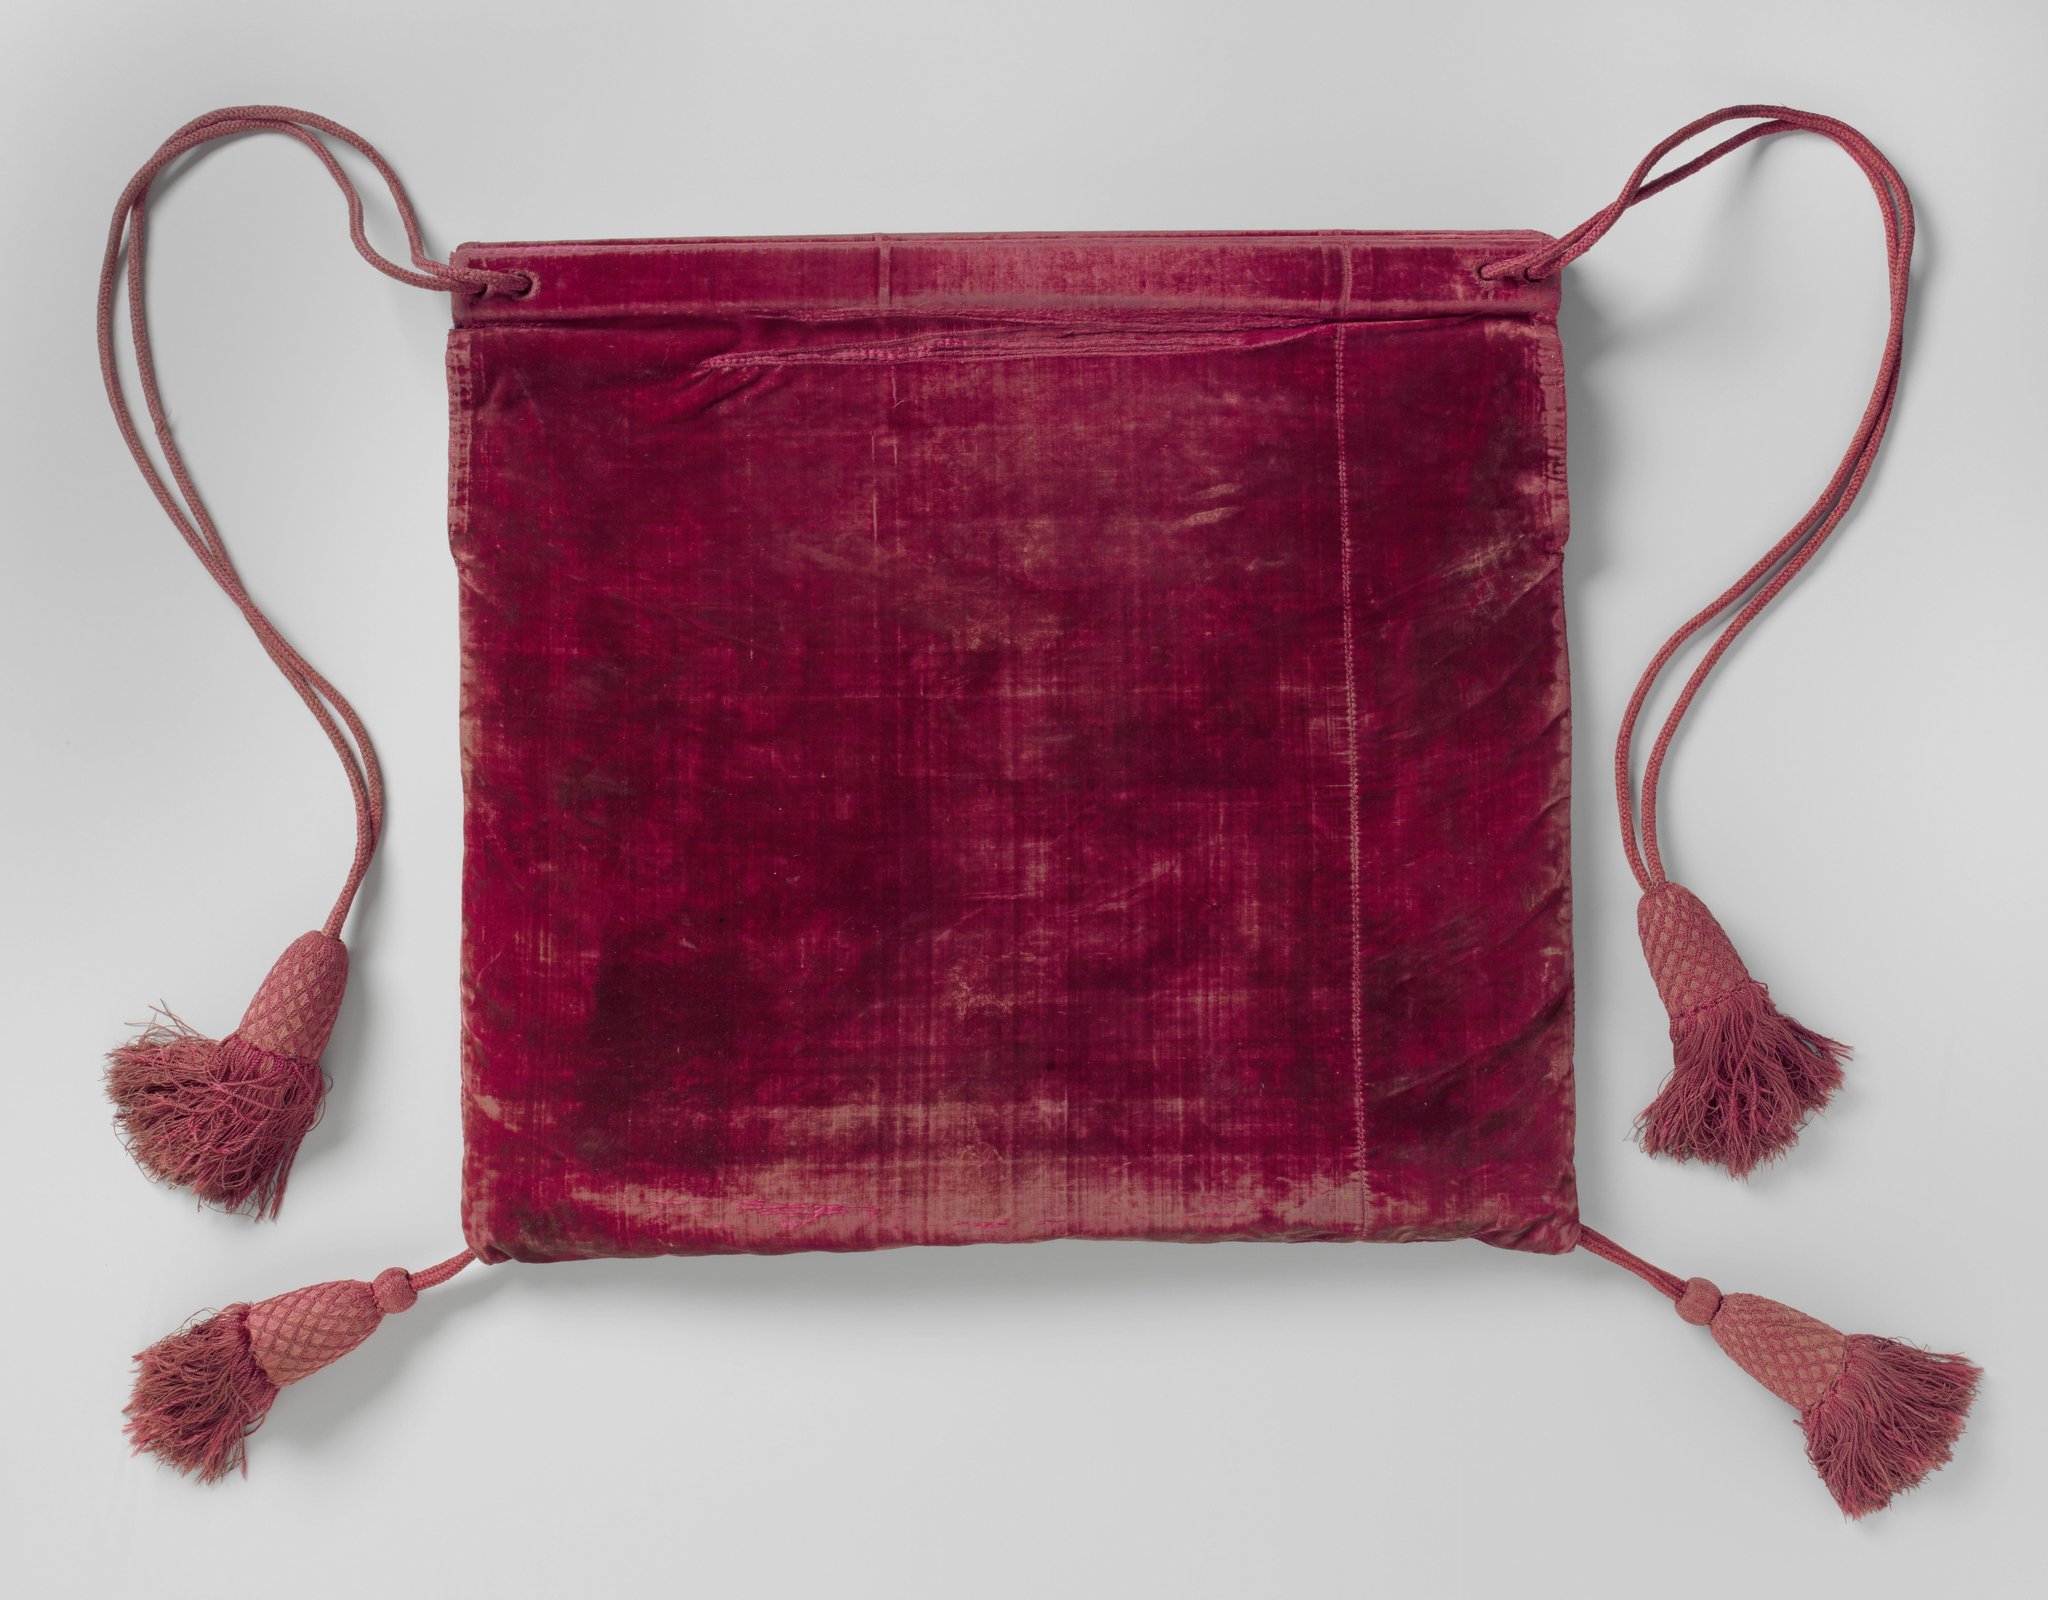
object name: zegeltas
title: Zegeltas Johan de Witt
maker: Anonymous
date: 1600-1700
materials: velvet, wood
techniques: cutting, weave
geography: netherlands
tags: the hague, politician, johan de witt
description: Tas van rood fluweel, met rode koorden en kwasten, bovenaan met houten latjes verstevigd. Volgens overlevering afkomstig van Johan de Witt, kan voor het Grootzegel der Staten bedoeld zijn. Grootzegelbewaarderstas.